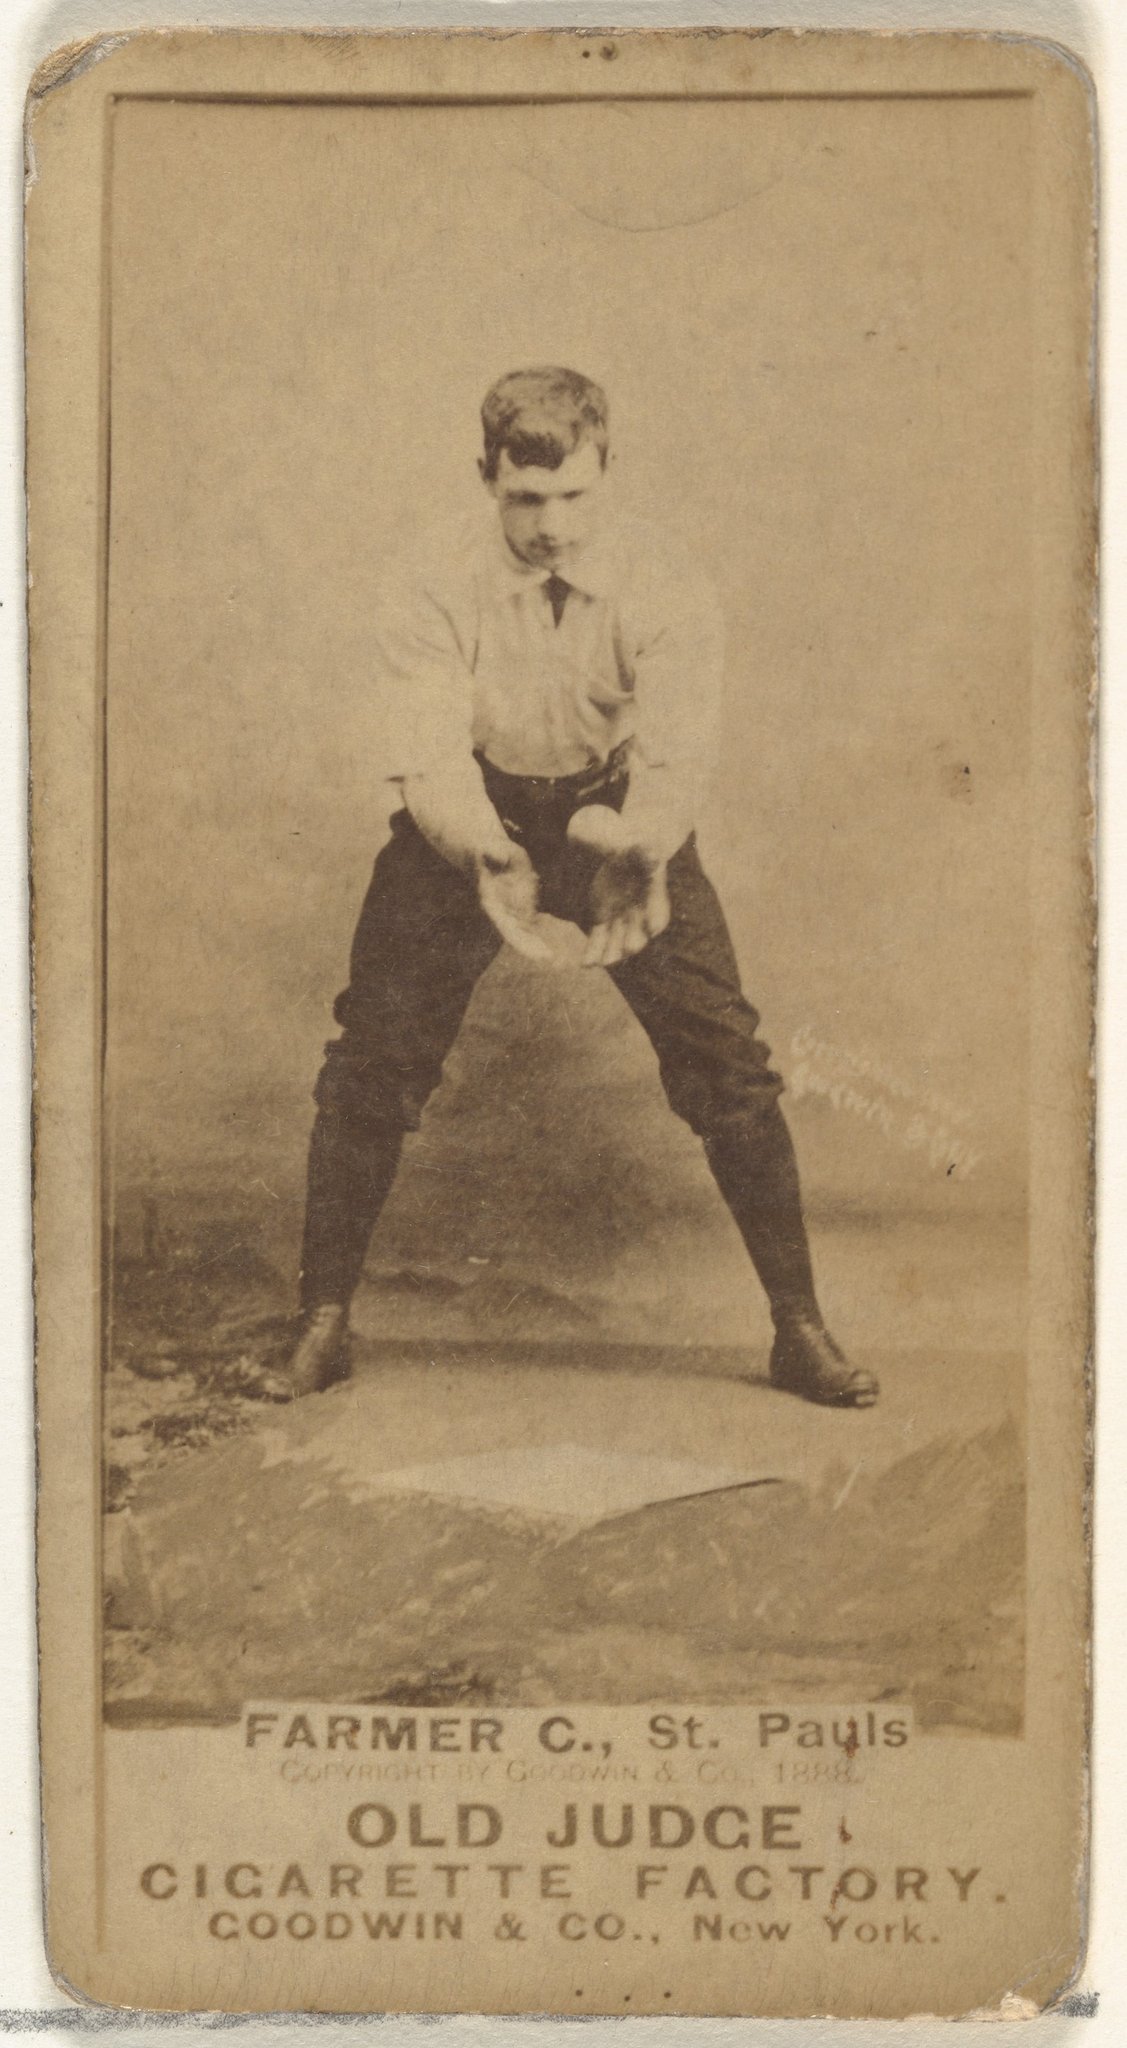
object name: baseball card, photograph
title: William Charles "Bill" Farmer, Catcher, St. Paul Apostles, from the Old Judge series (N172) for Old Judge Cigarettes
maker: goodwin & company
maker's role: publisher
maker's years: 1850-1950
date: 1888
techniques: albumen silver print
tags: men,portraits,baseball,athletes